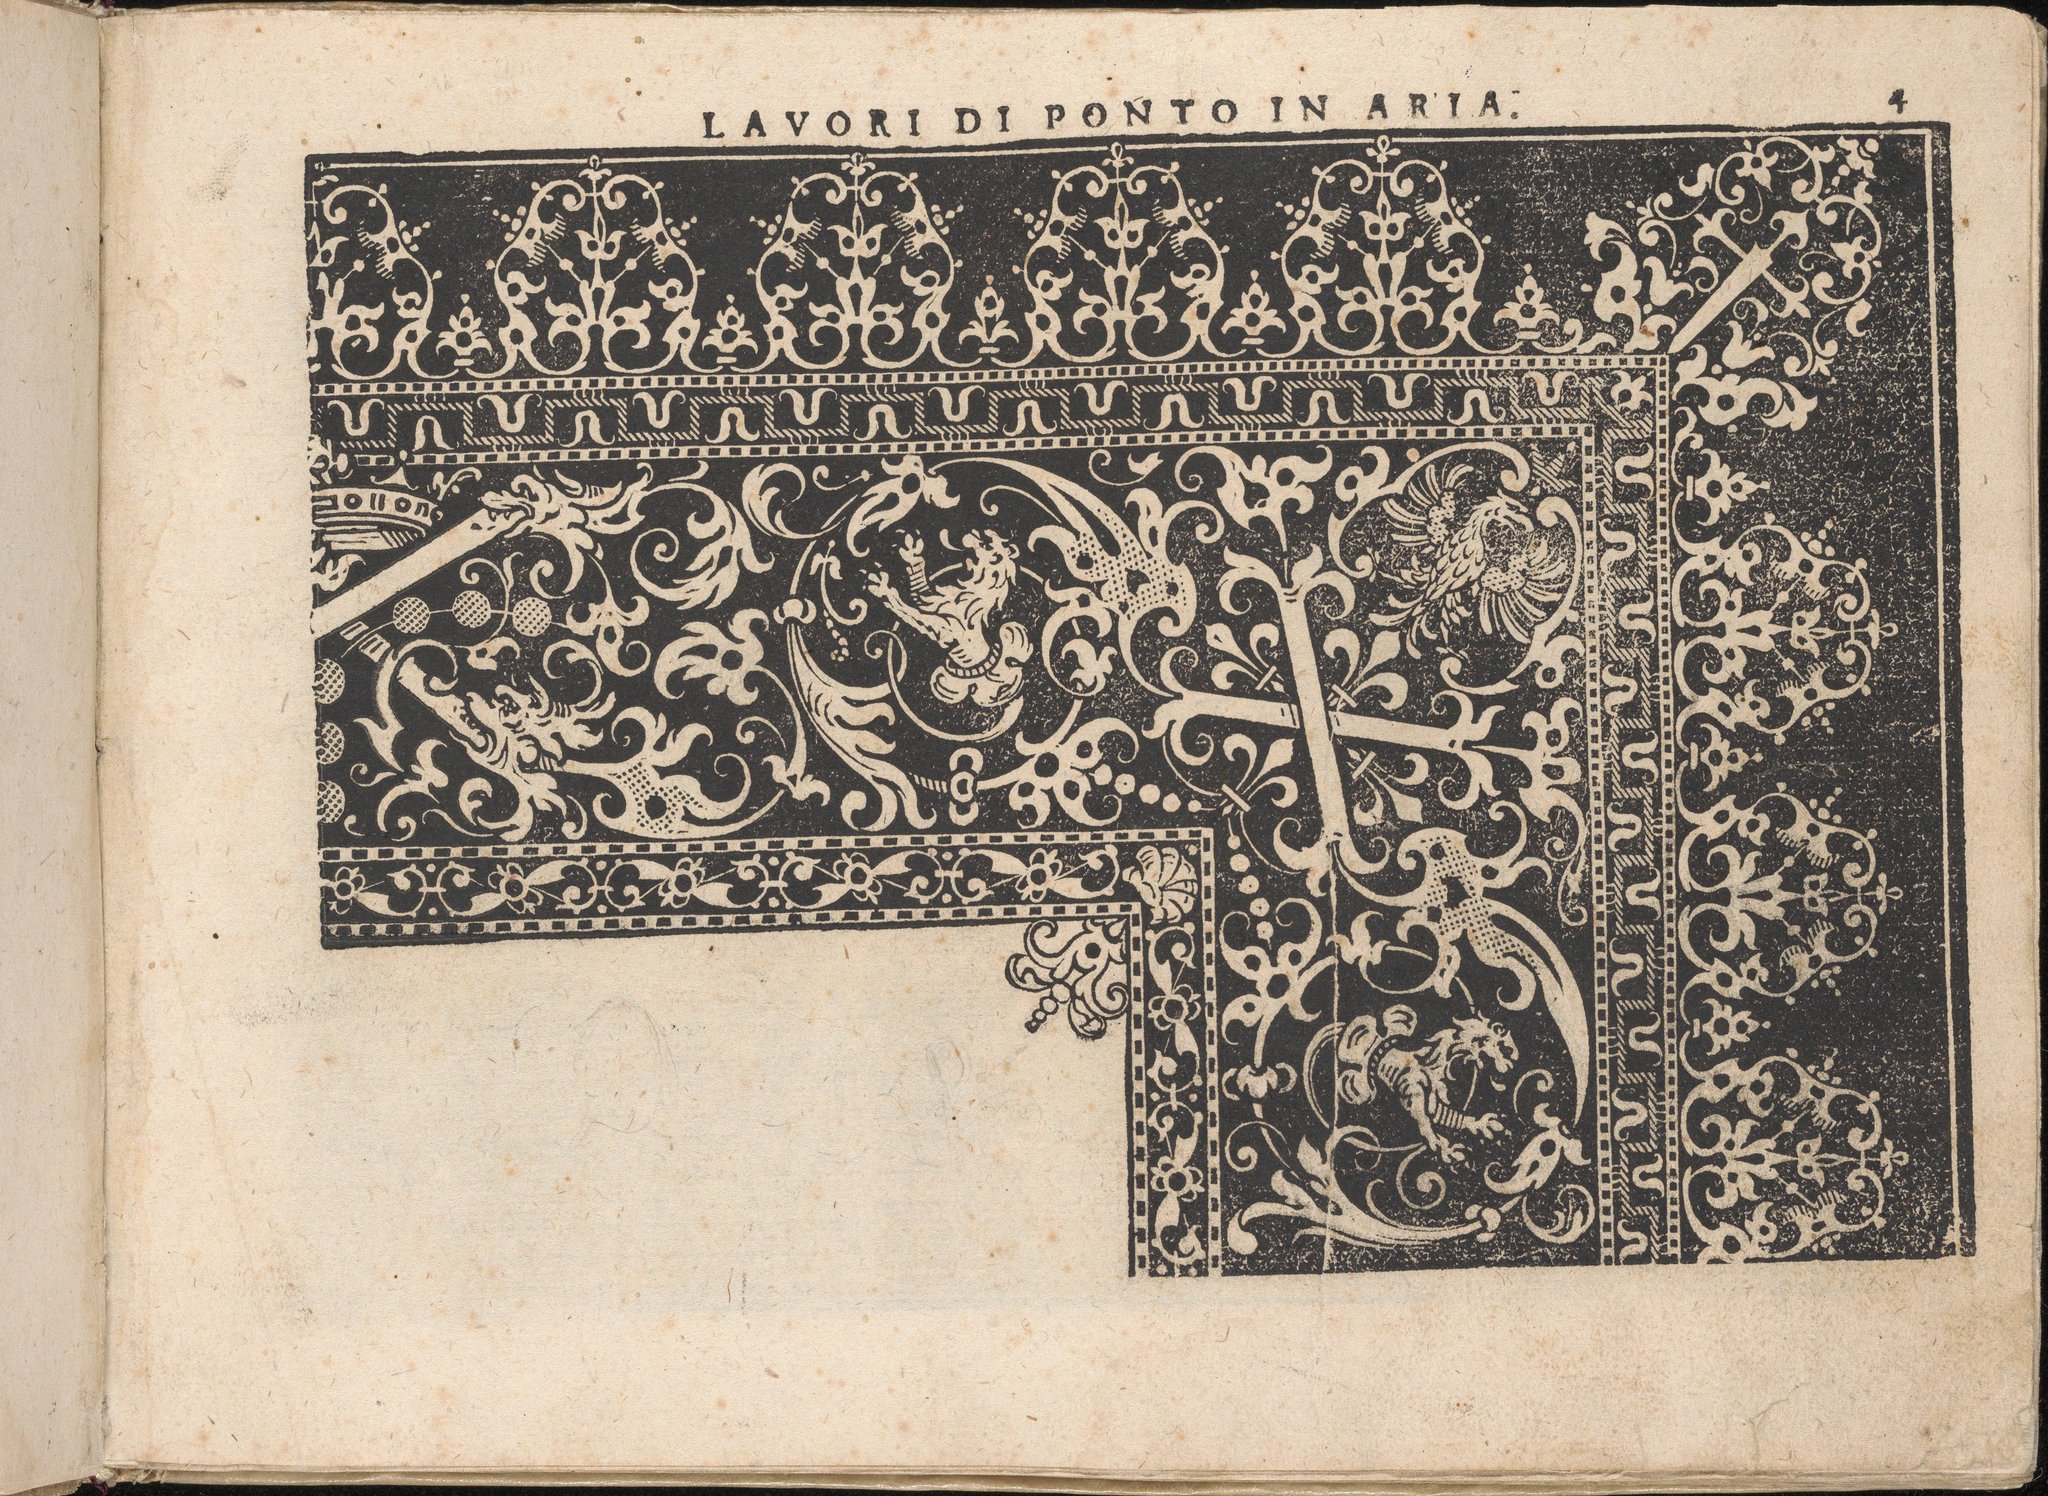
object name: book print ornament architecture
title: Fiore D'Ogni Virtu Per le Nobili Et Honeste Matrone, page 4 (recto)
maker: isabella catanea parasole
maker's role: designer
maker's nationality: italian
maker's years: 1565-1625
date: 1610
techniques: woodcut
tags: birds,lions,flowers